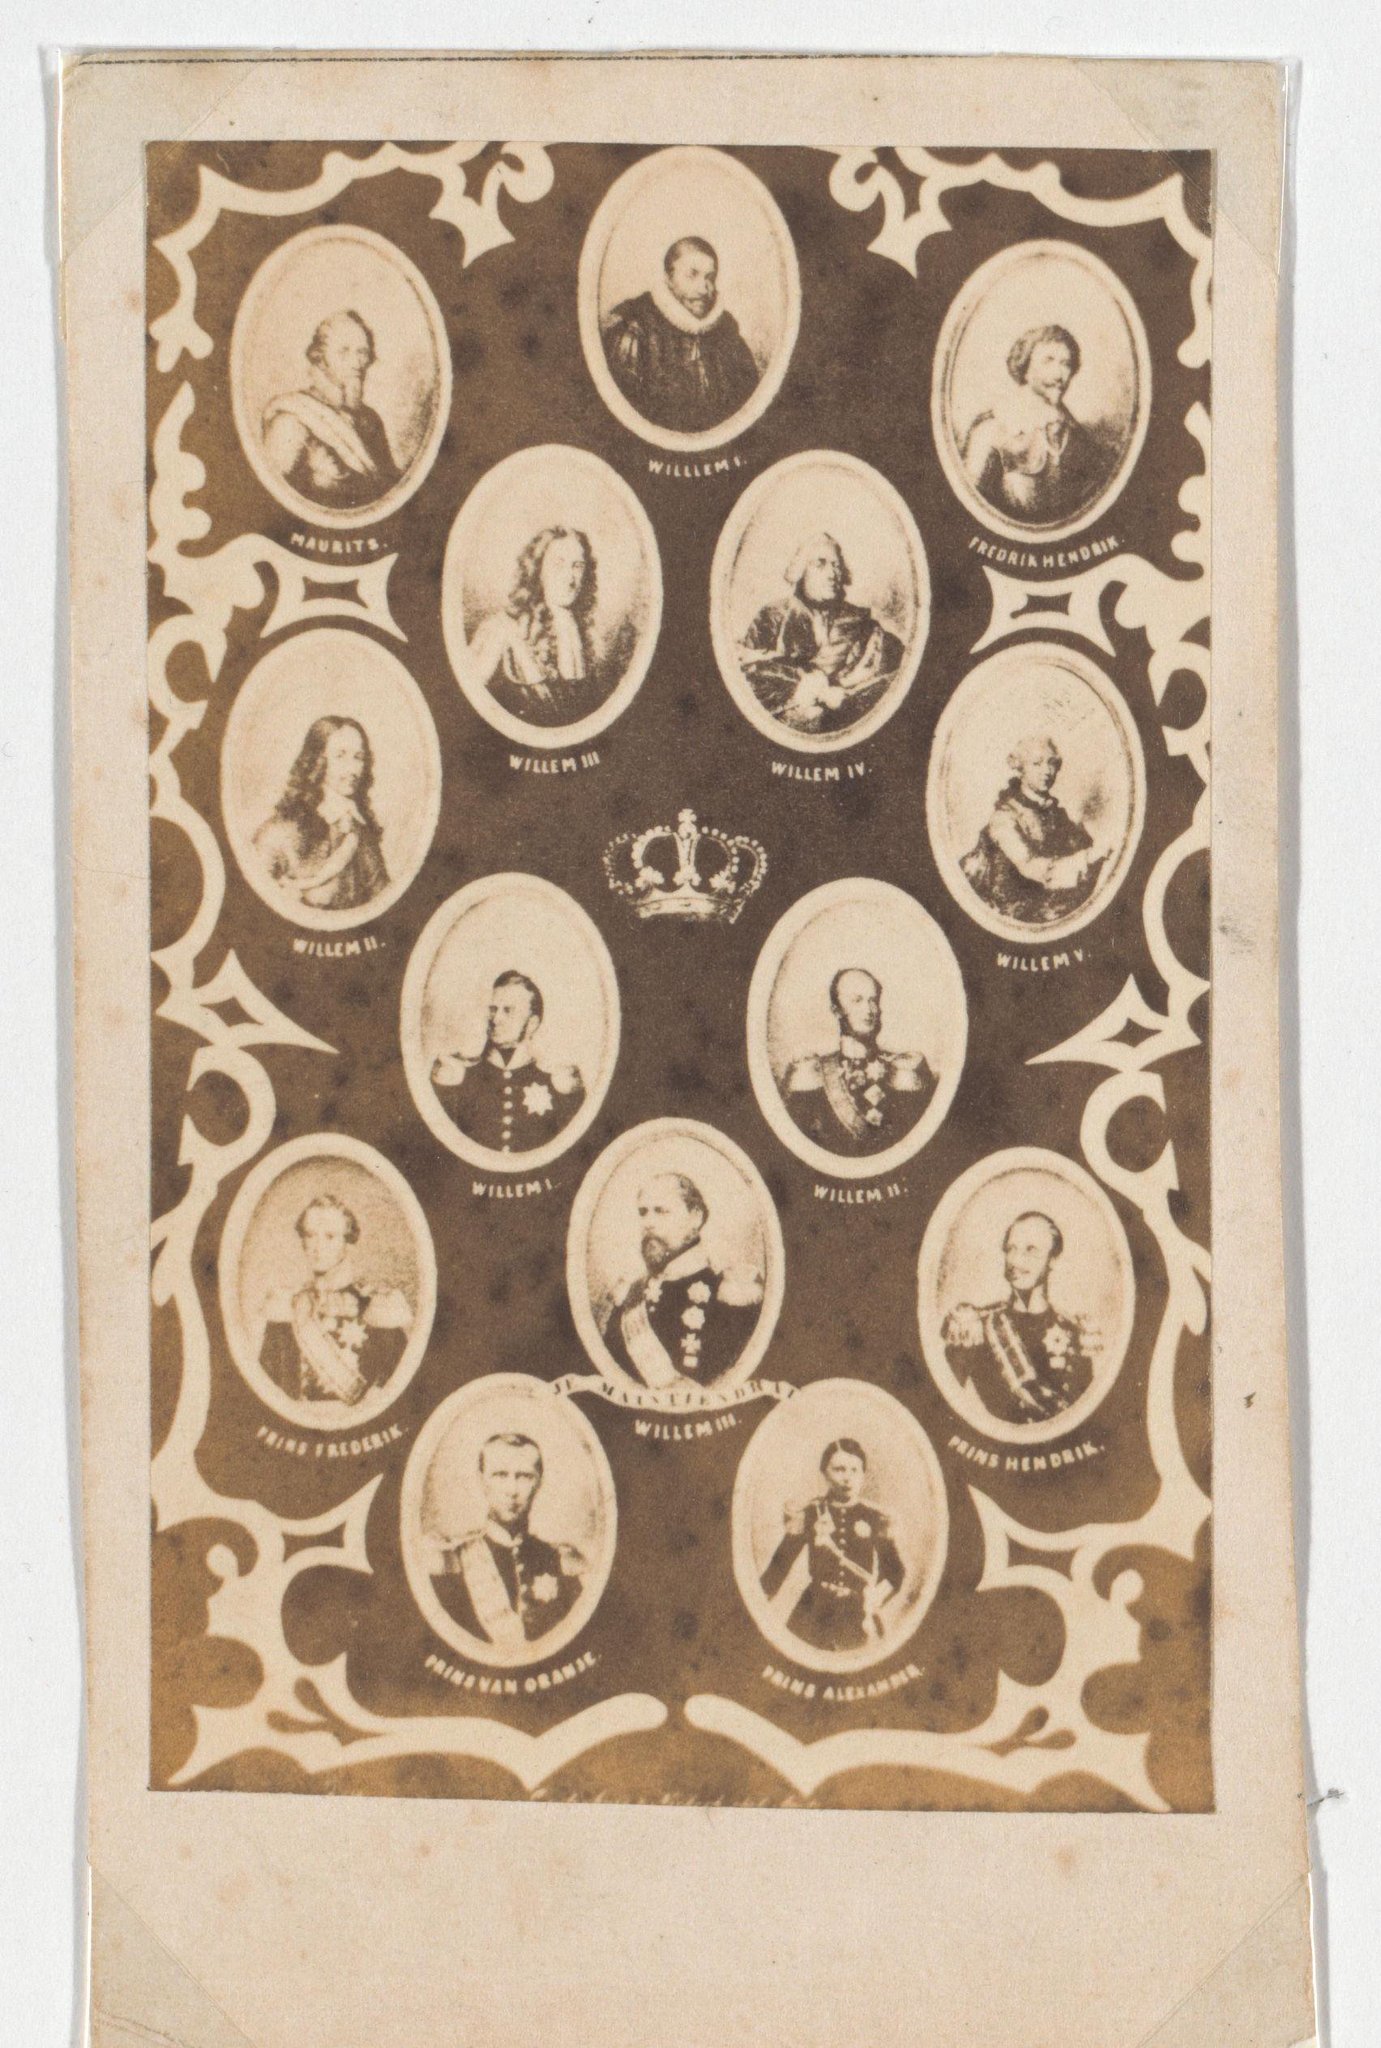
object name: photograph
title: Miniatuurportretten van leden van het Nederlandse Koninklijk Huis, van Willem de Zwijger tot prins Alexander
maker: Anonymous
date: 1860-1884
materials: cardboard, paper, photographic support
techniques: albumen print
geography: netherlands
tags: prince, historical persons, netherlands